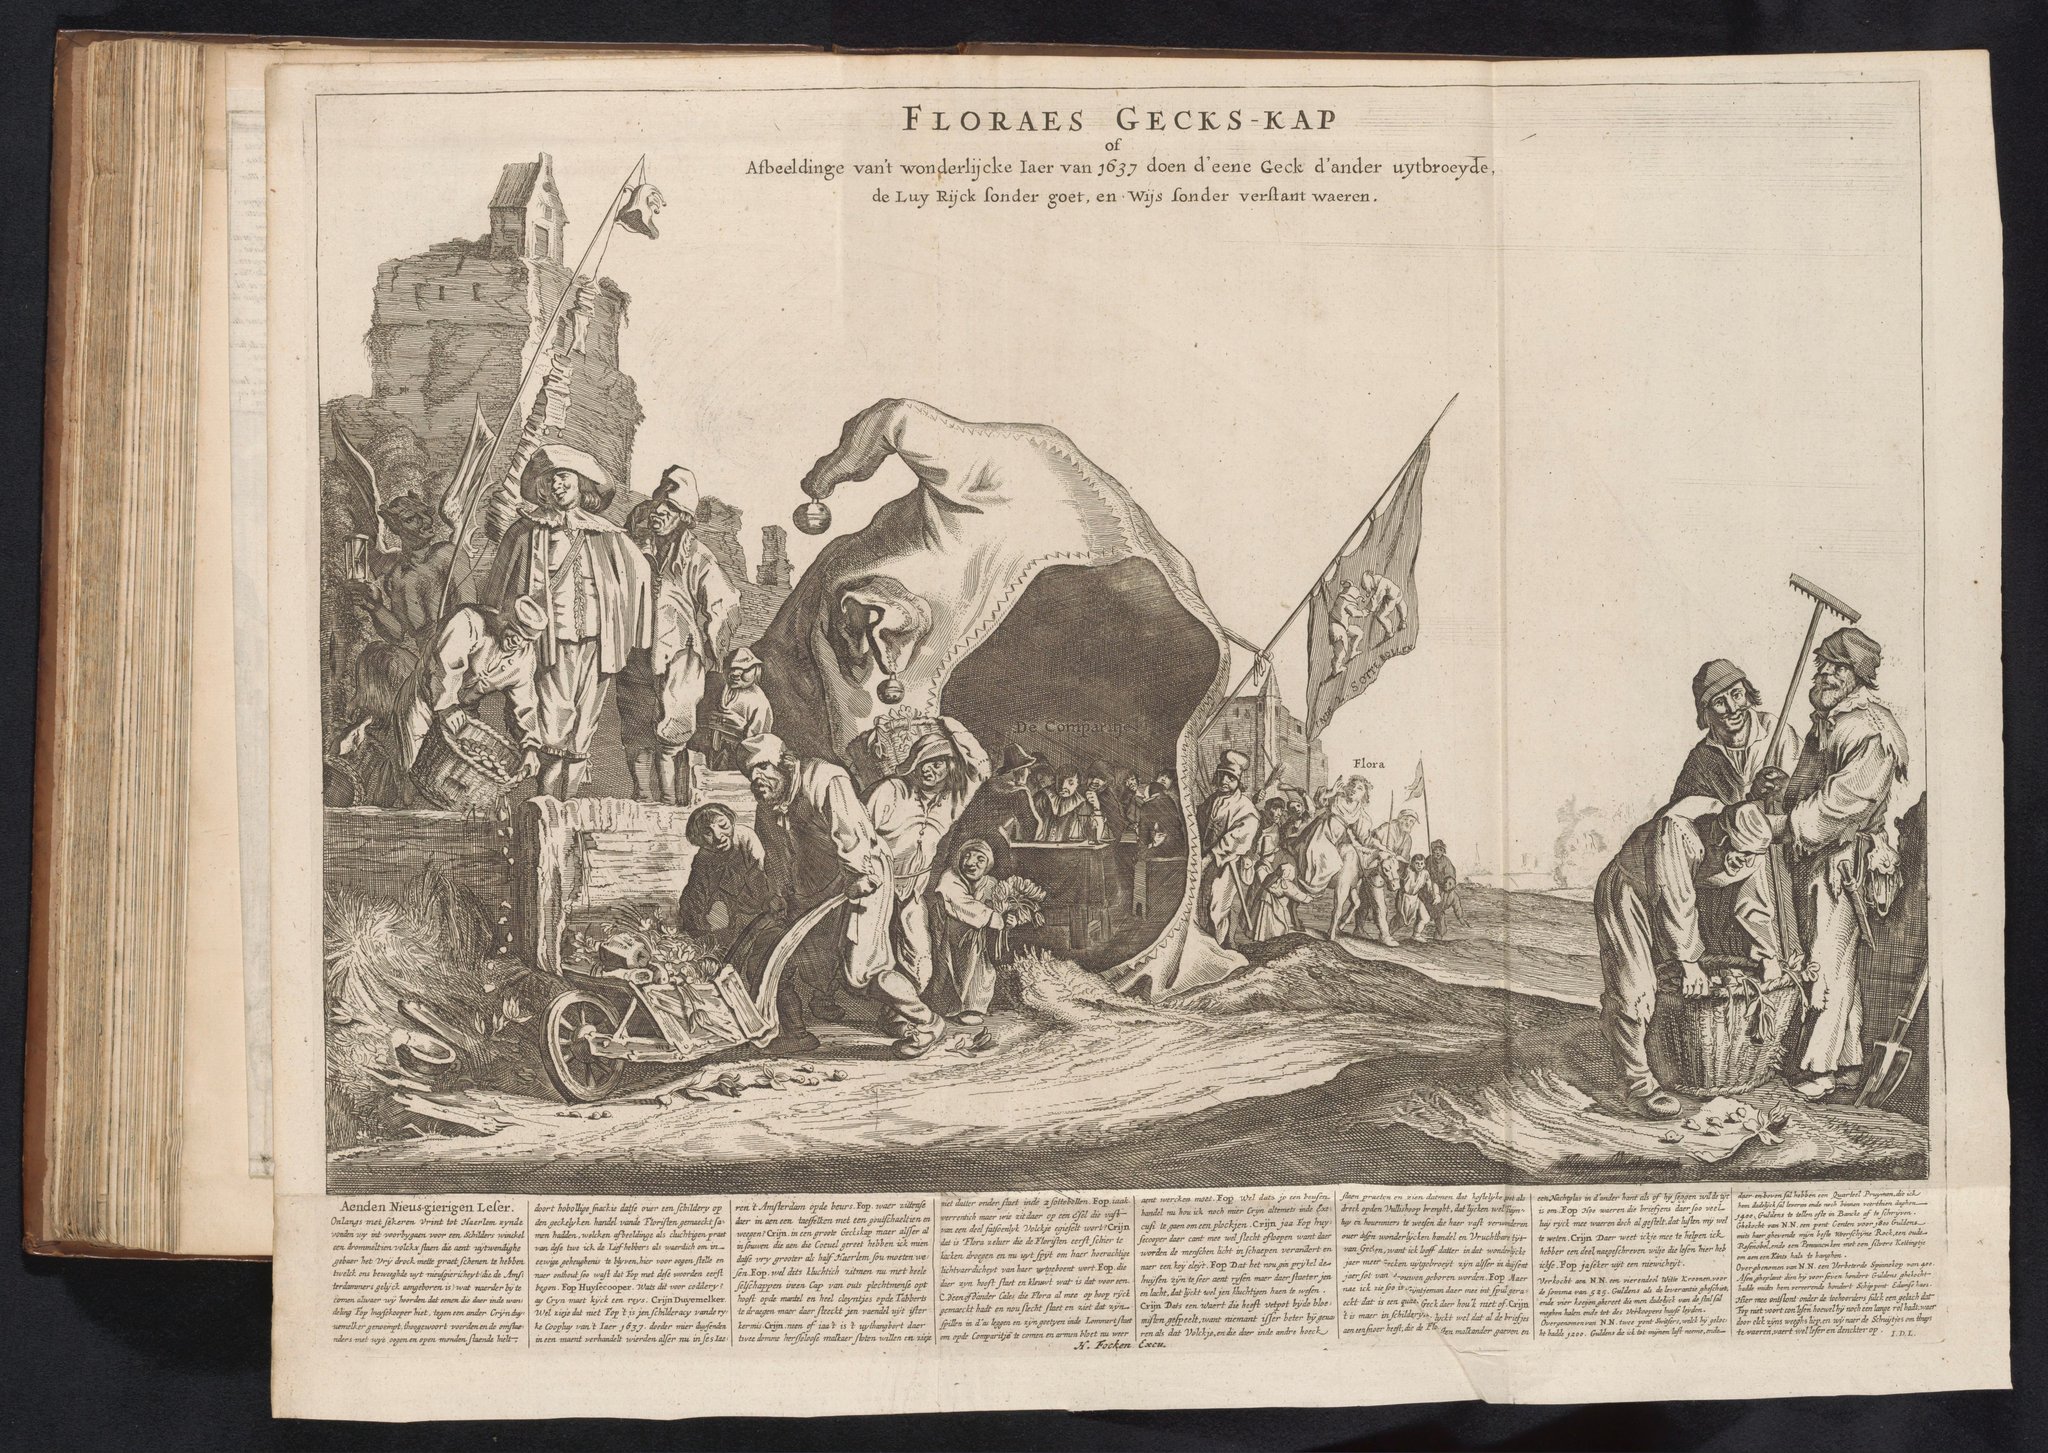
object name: print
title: Floraes Gecks-kap of Afbeeldinge van't wonderlijcke Jaer van 1637 doen d'eene Geck d'ander uytbroeyde, de Luy Rijck sonder goet, en wijs sonder verstant waeren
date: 1637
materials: paper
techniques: engraving, etching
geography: northern netherlands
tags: speculative boom, negative results and undesired aspects of trading, (story of) flora - suffering, misfortune, fool's cap, flowers: tulip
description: Floraes Gecks-kap. Herdruk uit 1720 van de spotprent op de tulpenmanie, windhandel in tulpenbollen in het jaar 1637. In een herberg in de vorm van een grote narrenkap zitten tulpenhandelaren. Links op een verhoging staat de duivel met een zandloper, handelaren met een stok met inschrijvingen en een boer die een mand met bollen op de mesthoop omkeert. Daarvoor en rechtsvooraan verschillende bollenboeren. Op de achtergrond wordt Flora gezeten op een ezel weggejaagd. Onder de voorstelling een lange tekst in 8 kolommen in het Nederlands. Prent in de gebonden eerste uitgave (304 B 11) van Het Groote Tafereel der Dwaasheid met spotprenten op de Windhandel of Actiehandel van 1720.